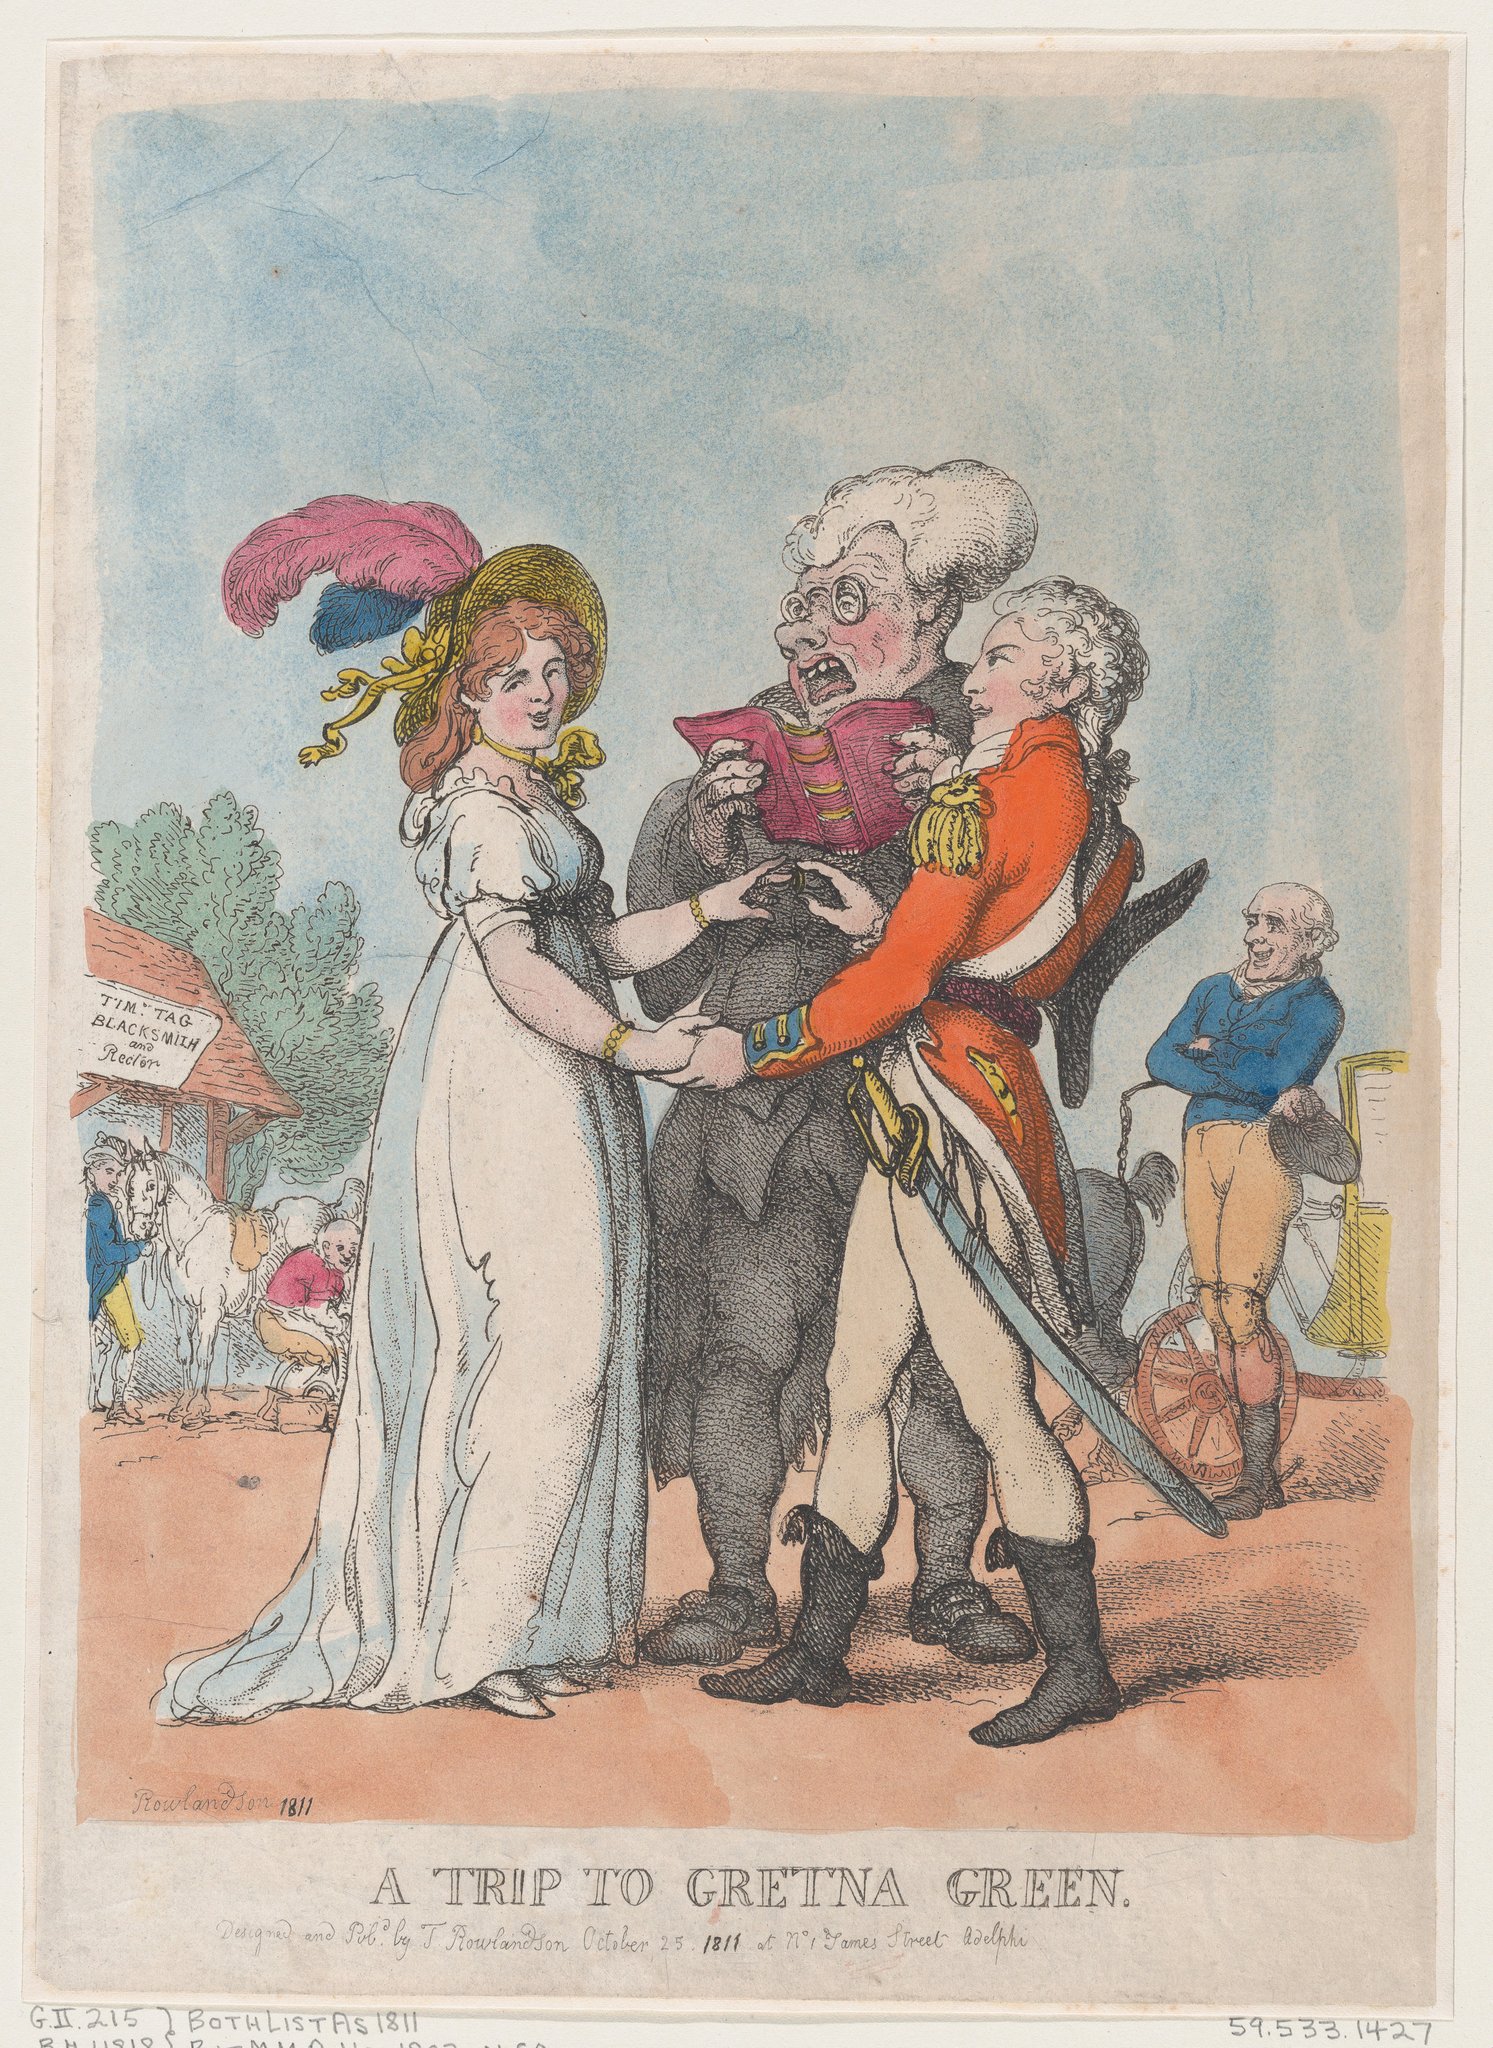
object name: print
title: A Trip to Gretna Green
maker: thomas rowlandson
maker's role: artist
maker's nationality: british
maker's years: 1757-1827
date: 1803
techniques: etching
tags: satire,men,women,weddings